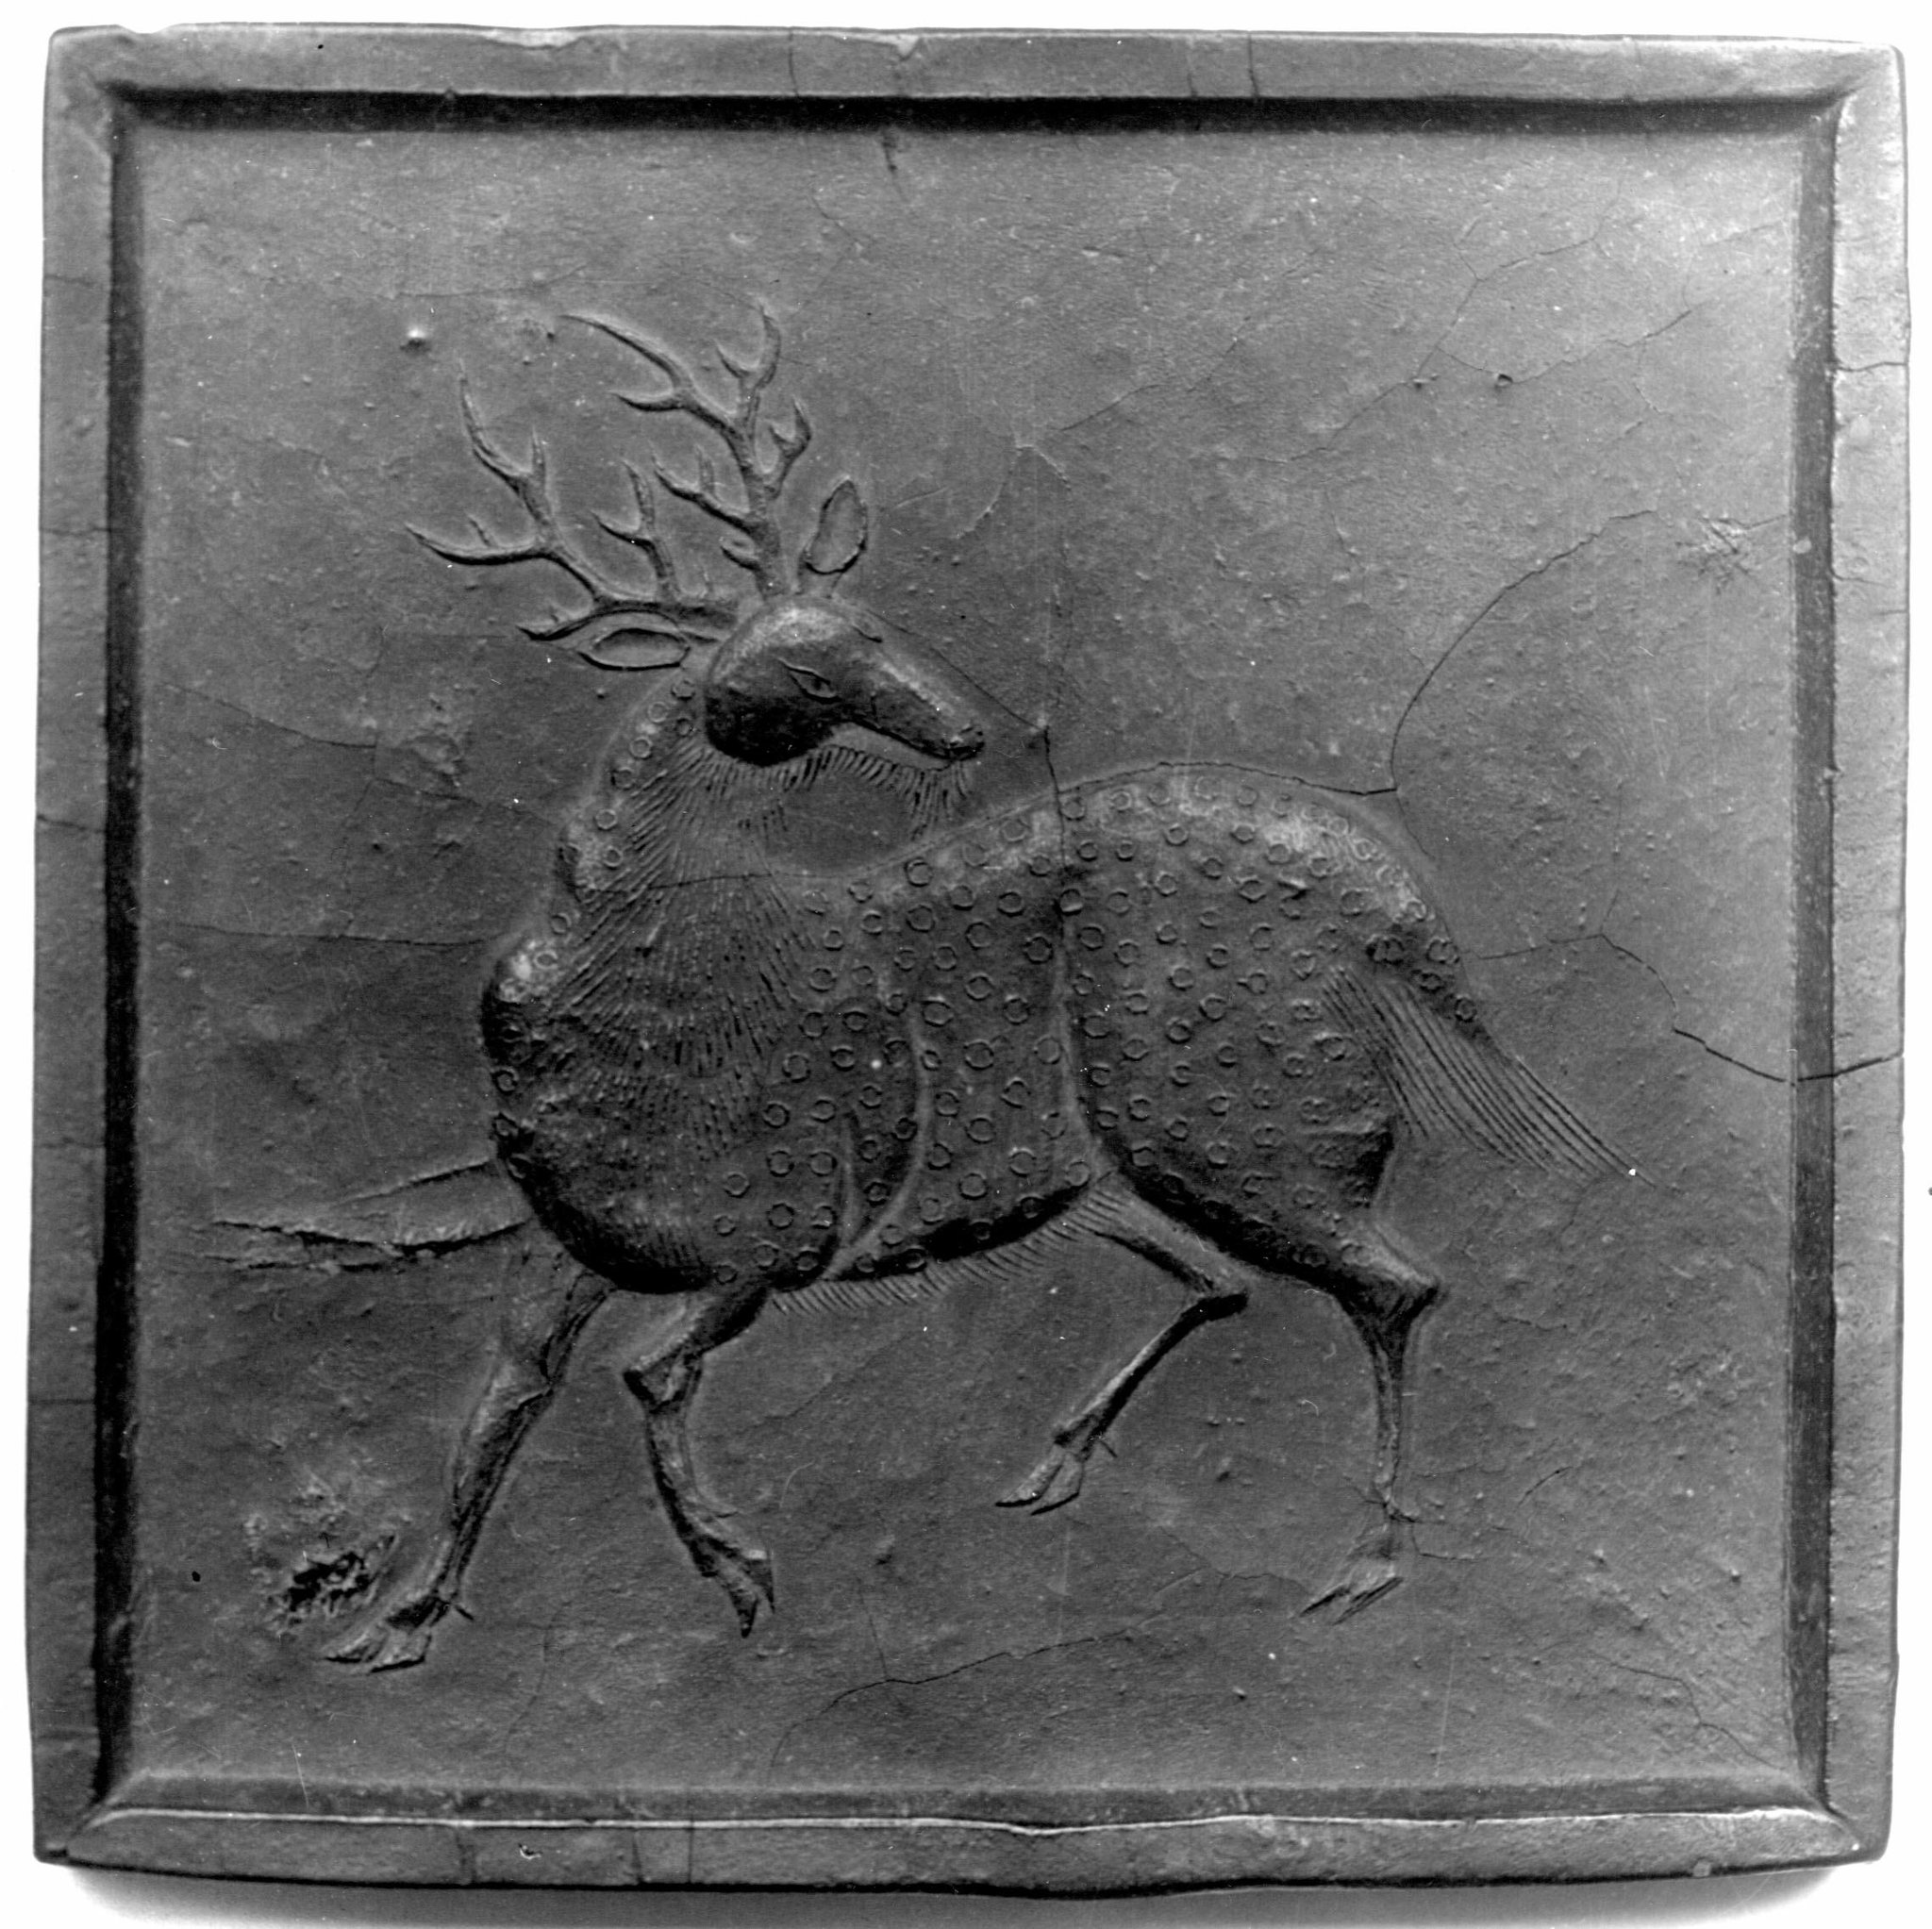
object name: ink tablet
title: Ink Tablet with Black Stag Motif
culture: chinese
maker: fang yulu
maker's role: artist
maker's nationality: chinese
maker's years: 1570-1619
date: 1867-1933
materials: ink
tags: deer